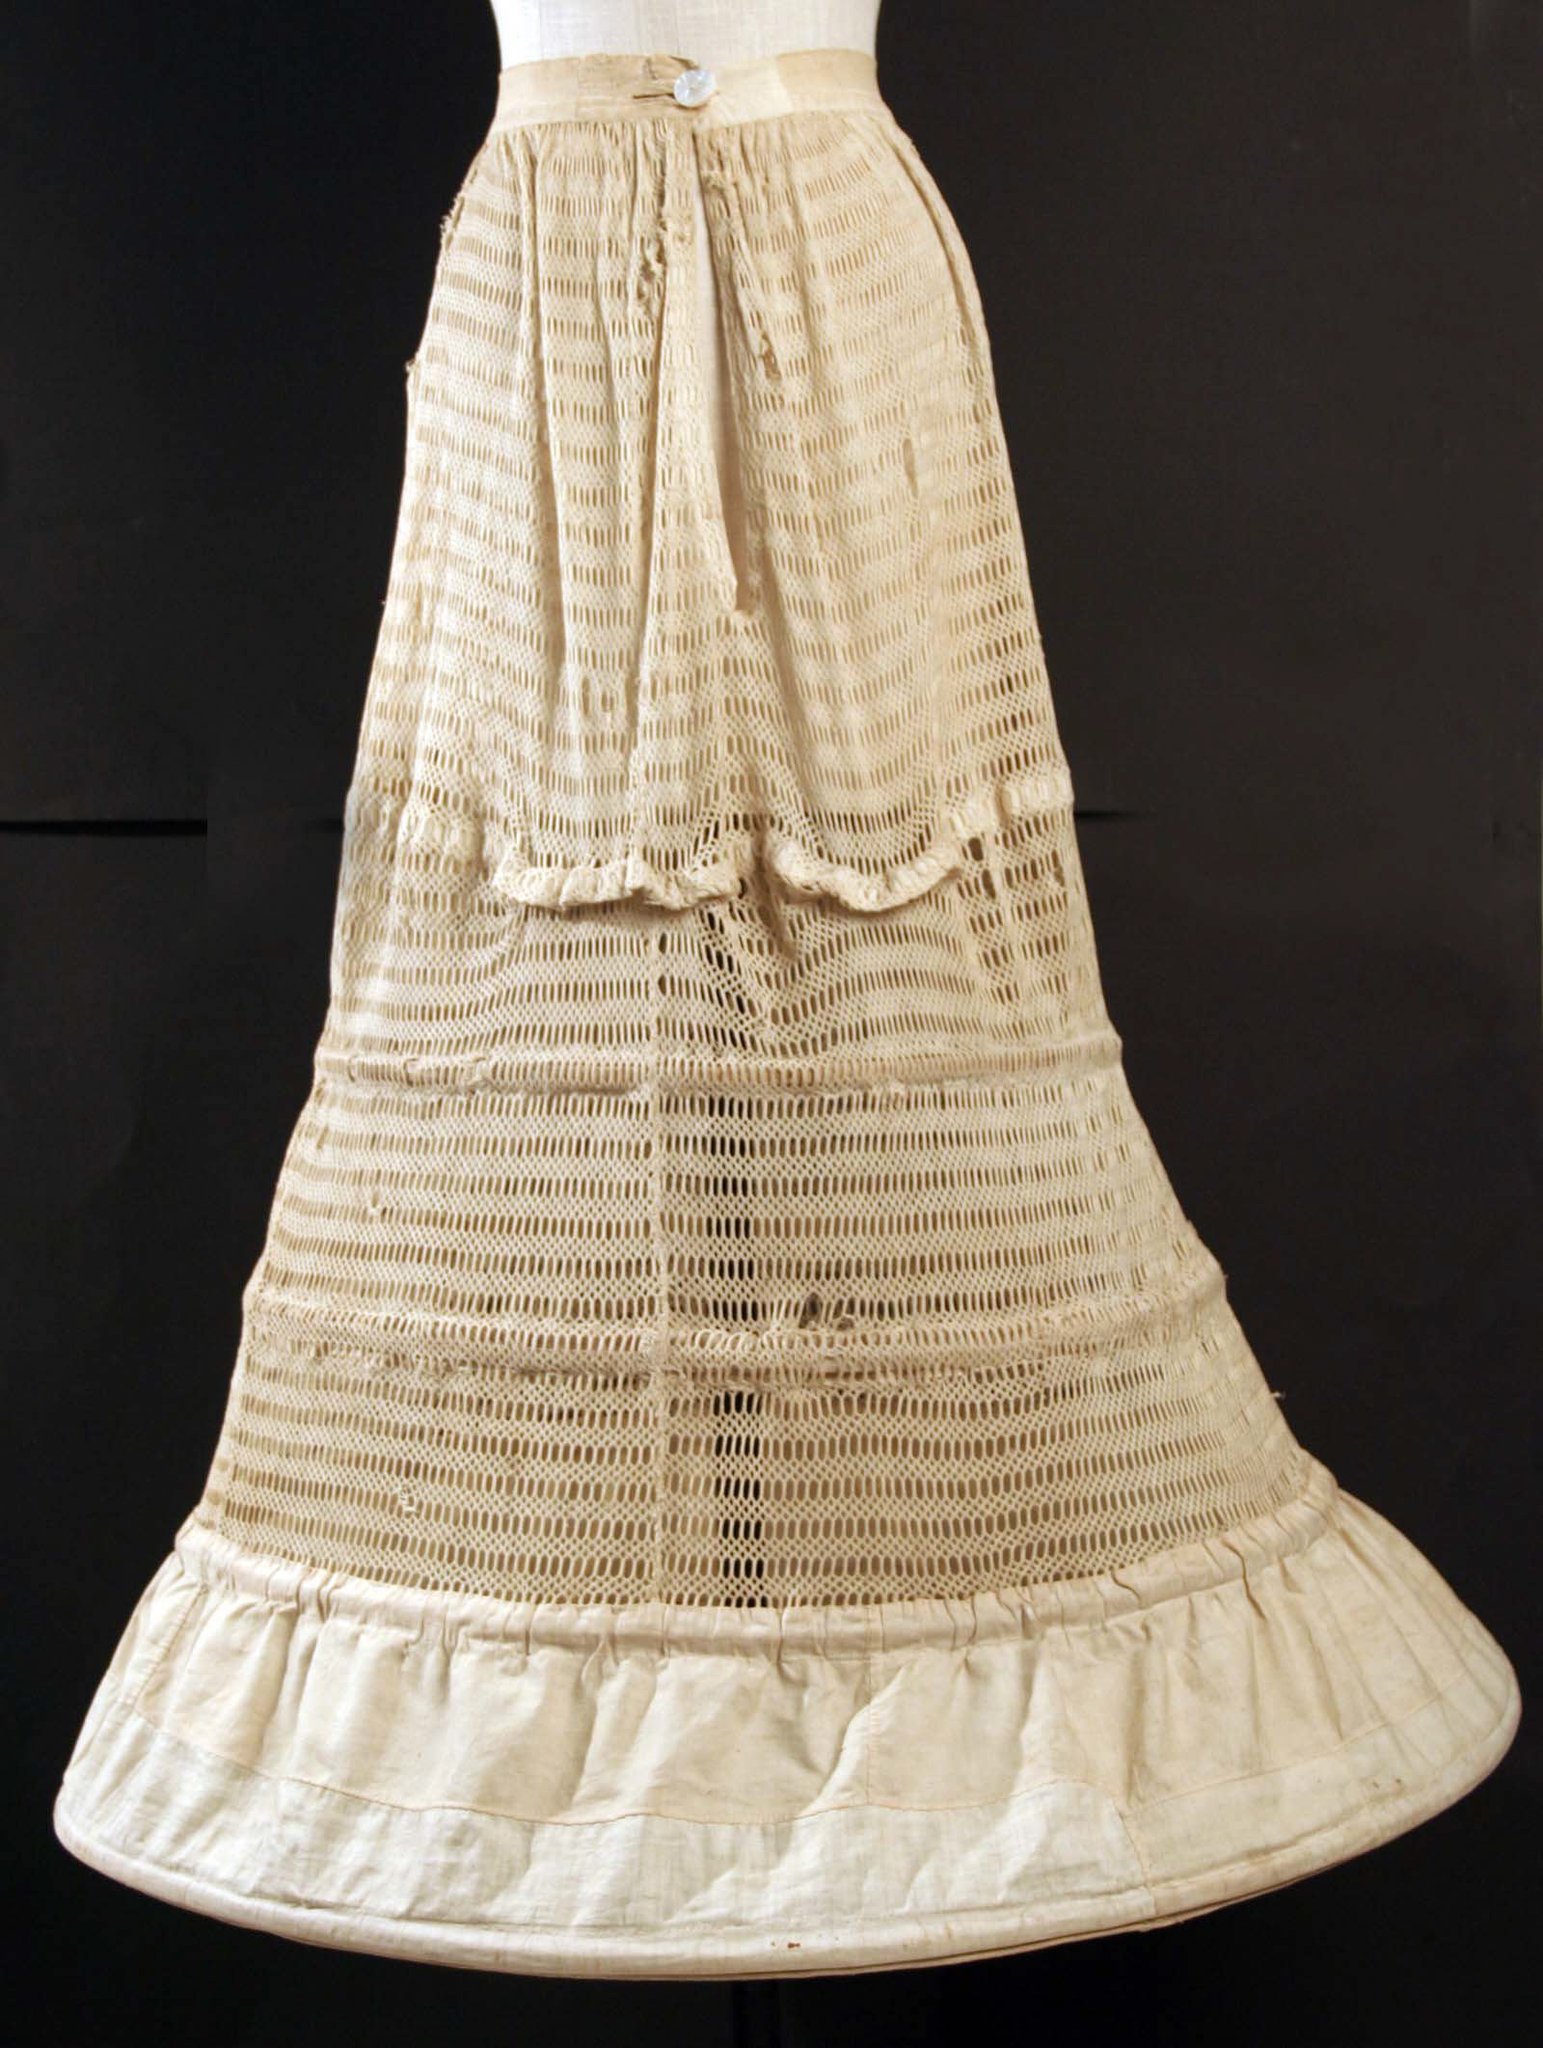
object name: cage crinoline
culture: american or european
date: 1850-1855